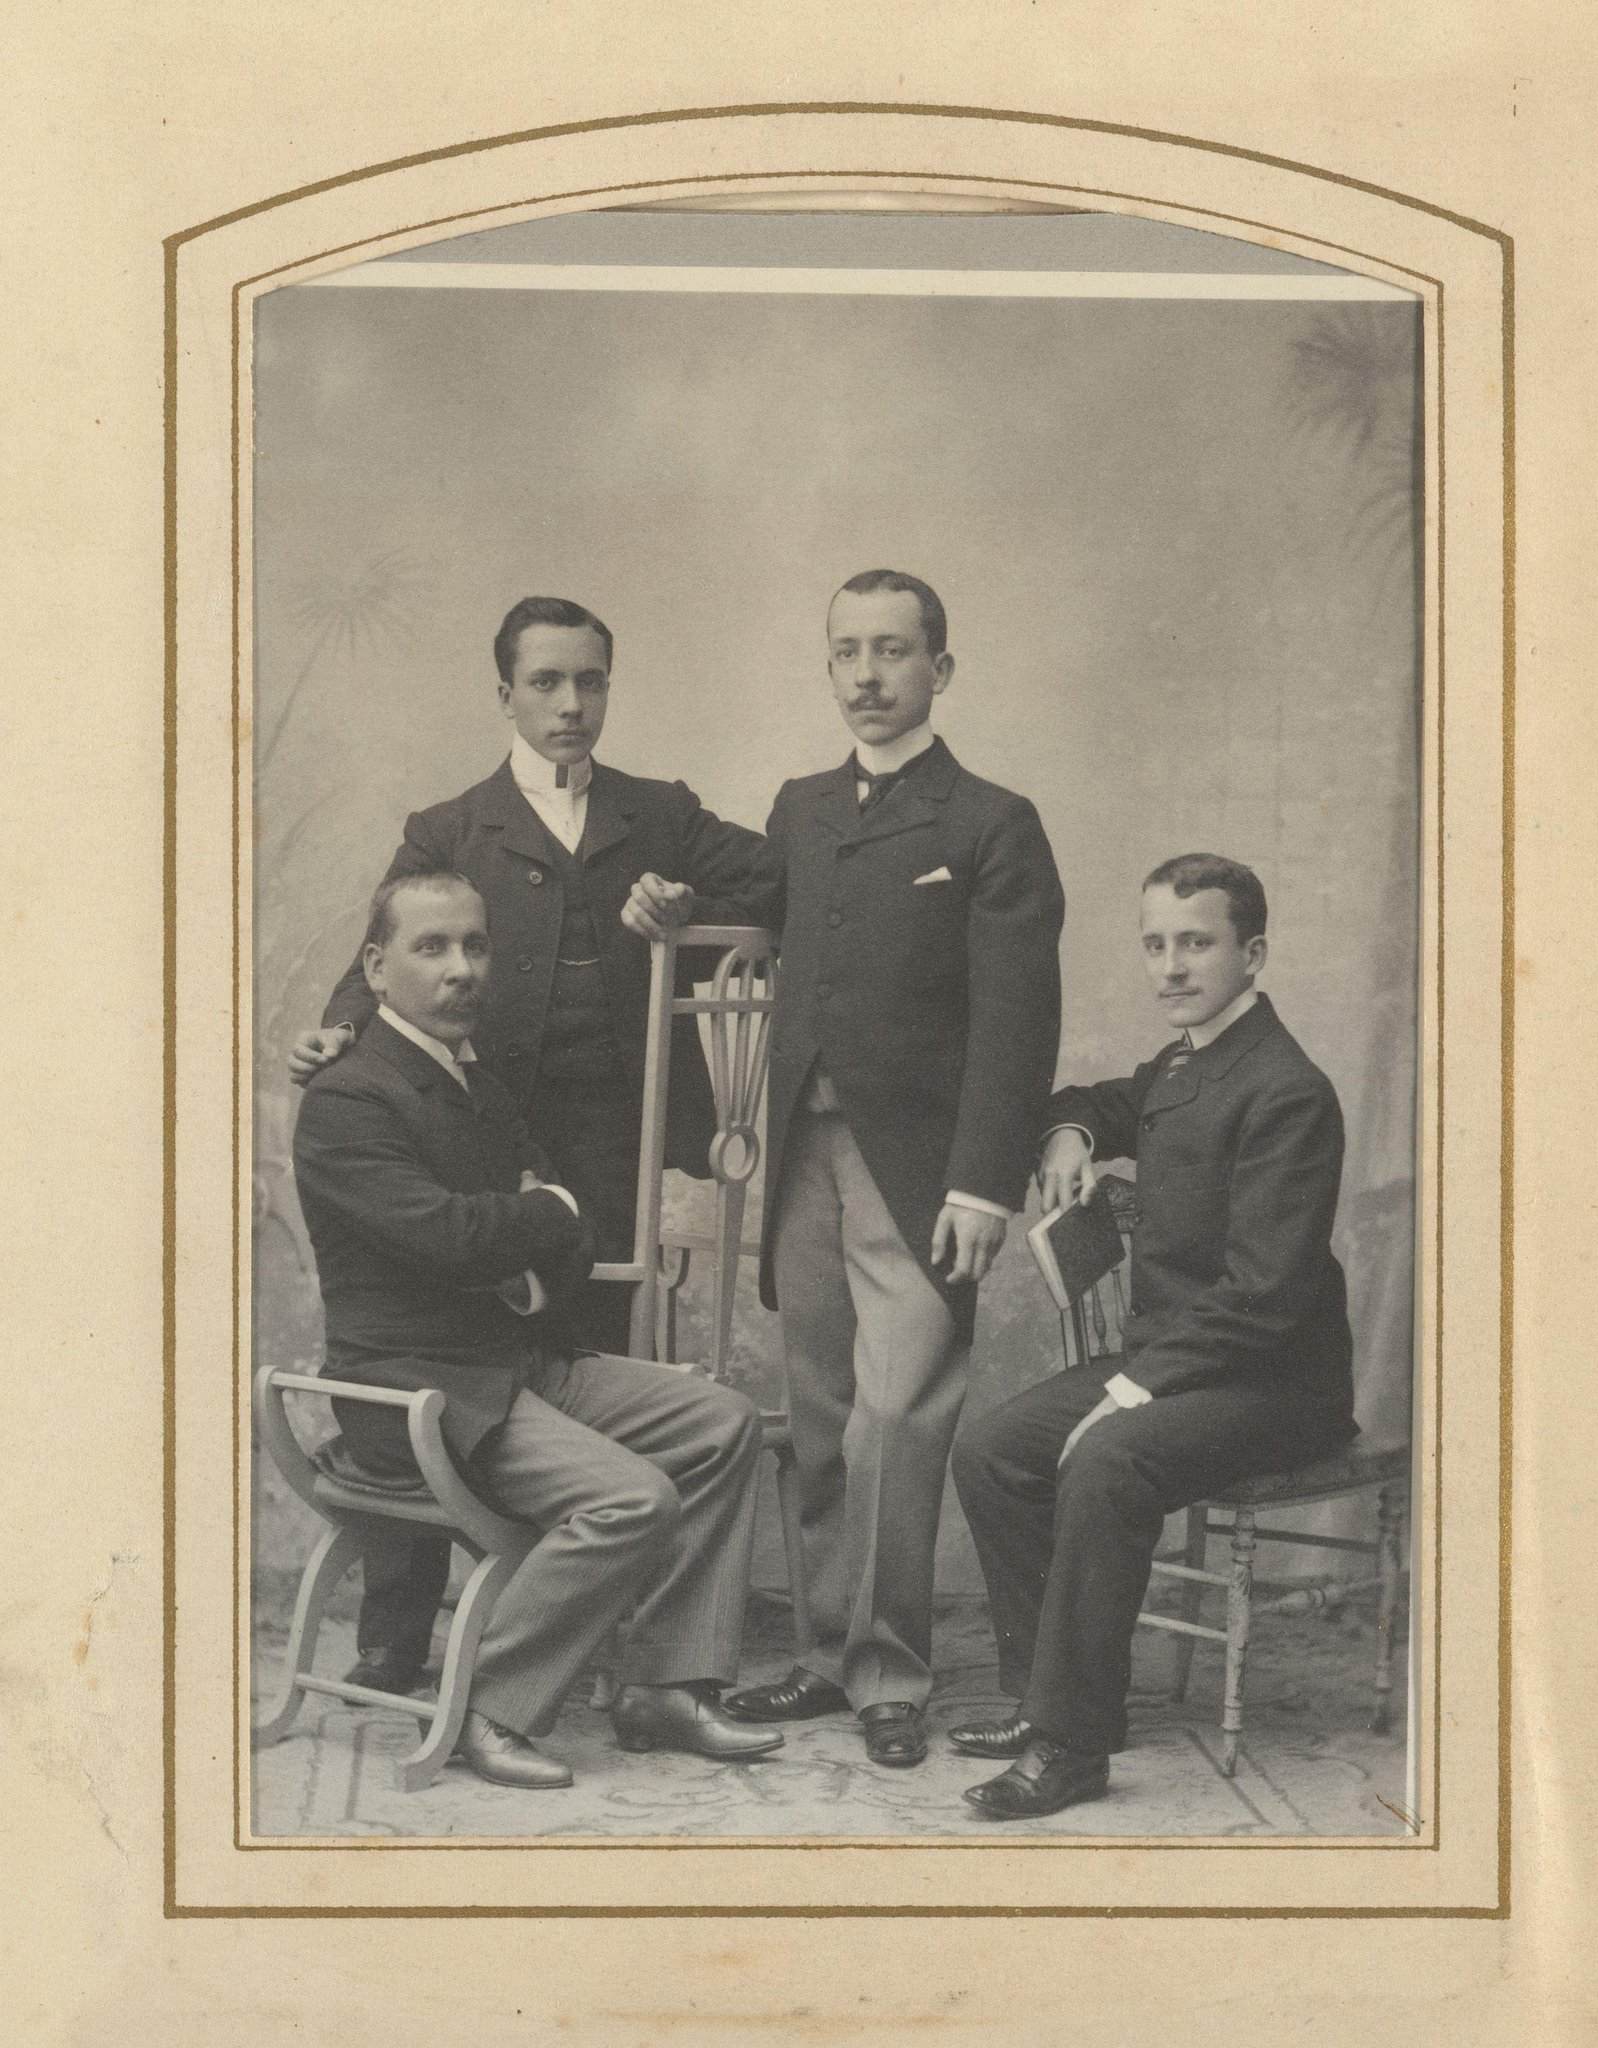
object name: photograph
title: Groepsportret van vier mannen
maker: Anonymous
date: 1880-1910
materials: cardboard, photographic support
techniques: platinum process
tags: standing figure, sitting figure, adult man, book, anonymous historical persons portrayed in a group, in a group-portrait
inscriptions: annotation: ‘[...]/ Belgium’